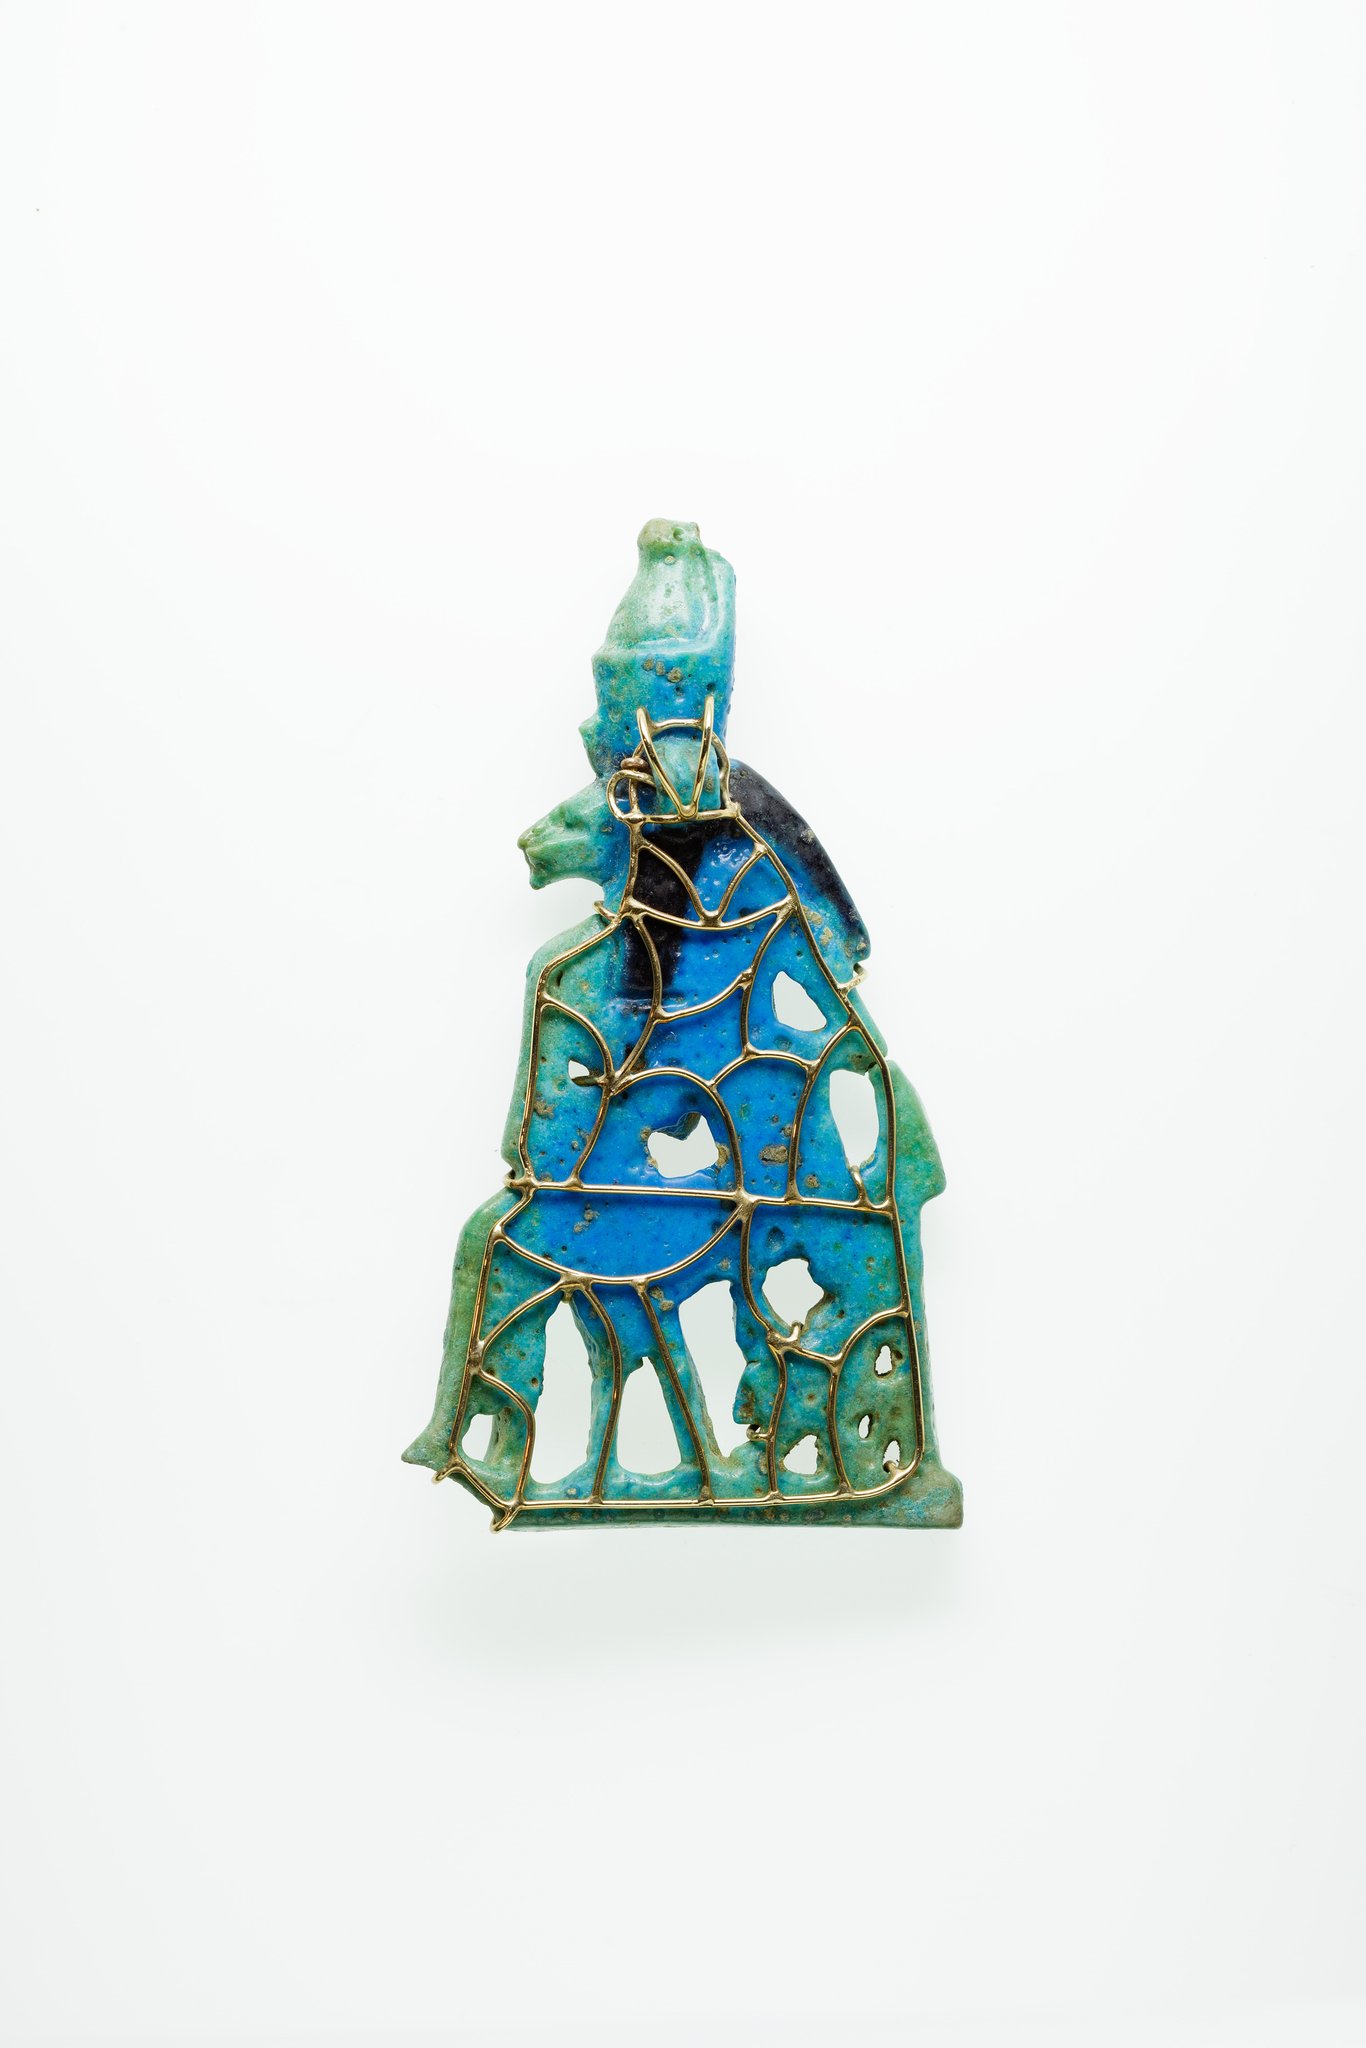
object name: inlay, modern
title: Modern setting for faience inlay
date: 1070-664 BCE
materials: gold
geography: egypt